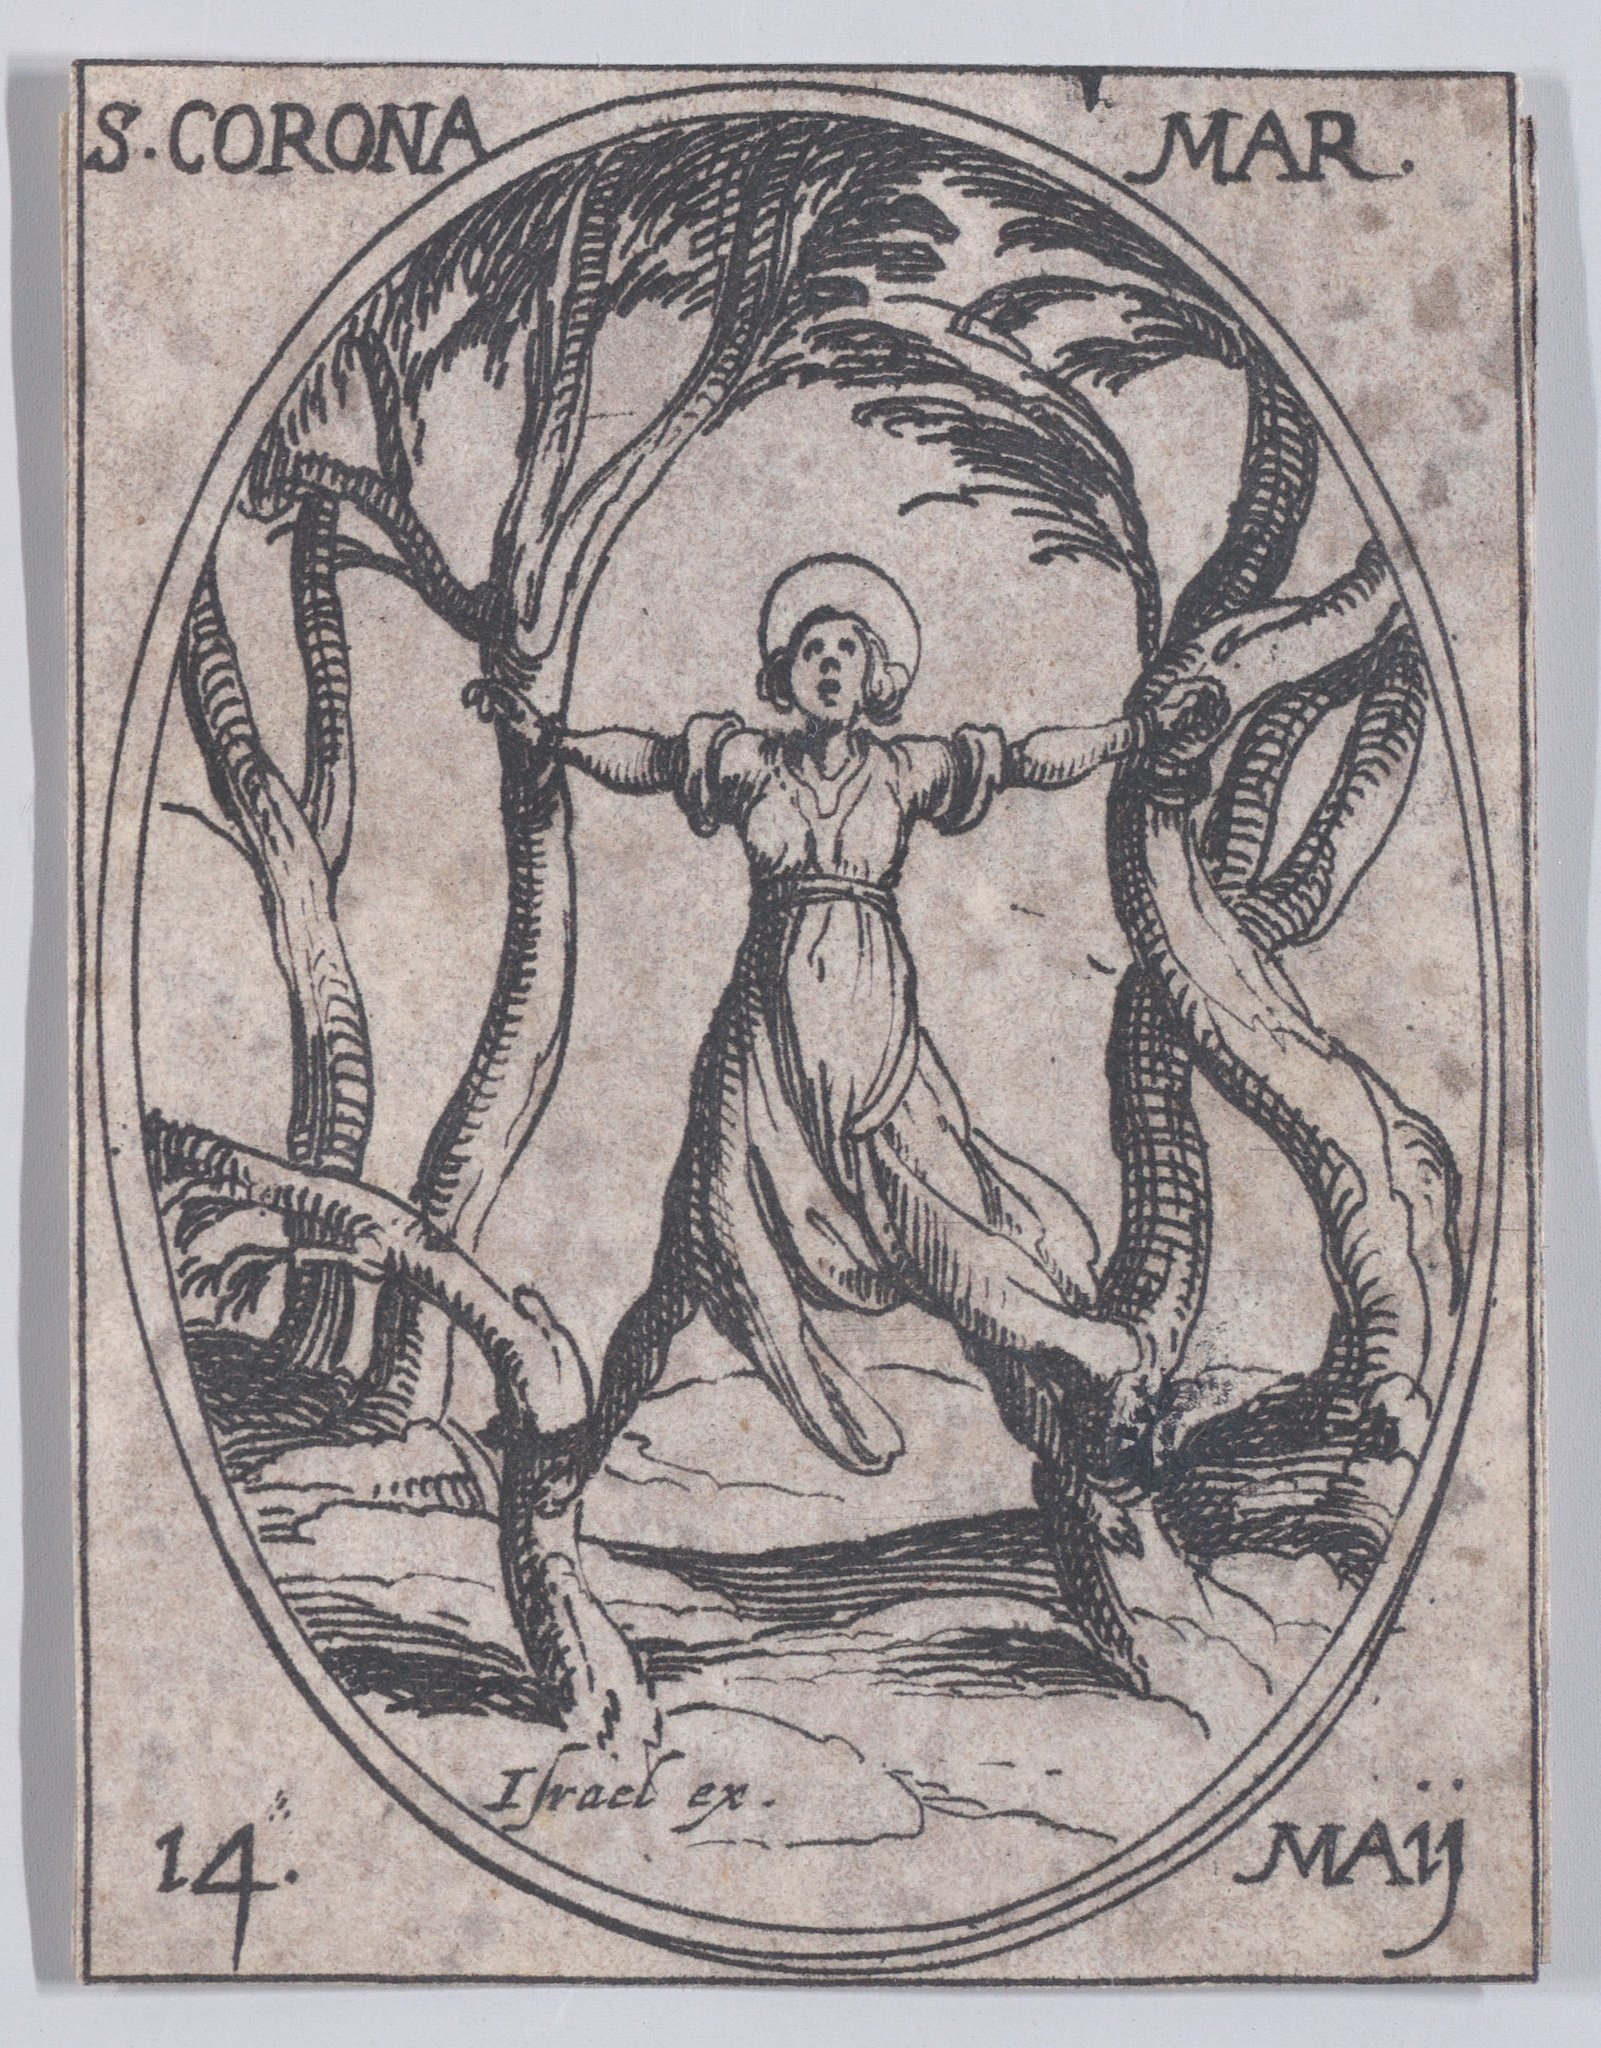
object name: print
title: Ste. Couronne, martyre (St. Corona, Martyr), May 14th, from "Les Images De Tous Les Saincts et Saintes de L'Année" (Images of All of the Saints and Religious Events of the Year)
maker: jacques callot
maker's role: artist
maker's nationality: french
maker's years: 1592-1635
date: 1636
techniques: etching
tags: women,saints